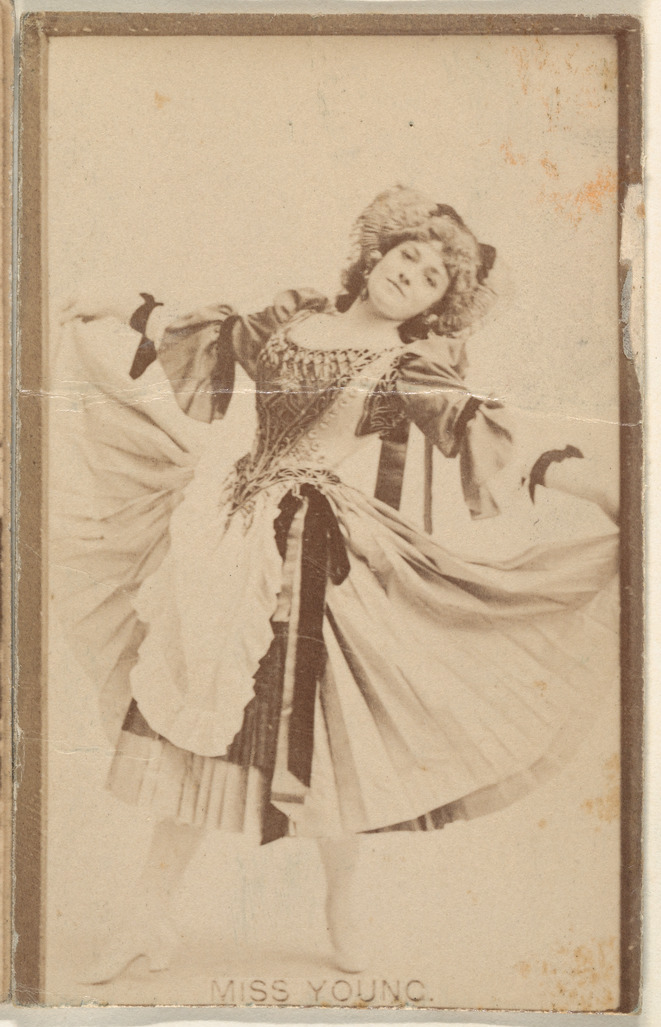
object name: photograph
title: Miss Young, from the Actresses series (N668)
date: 1888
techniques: albumen silver print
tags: portraits,women,actresses